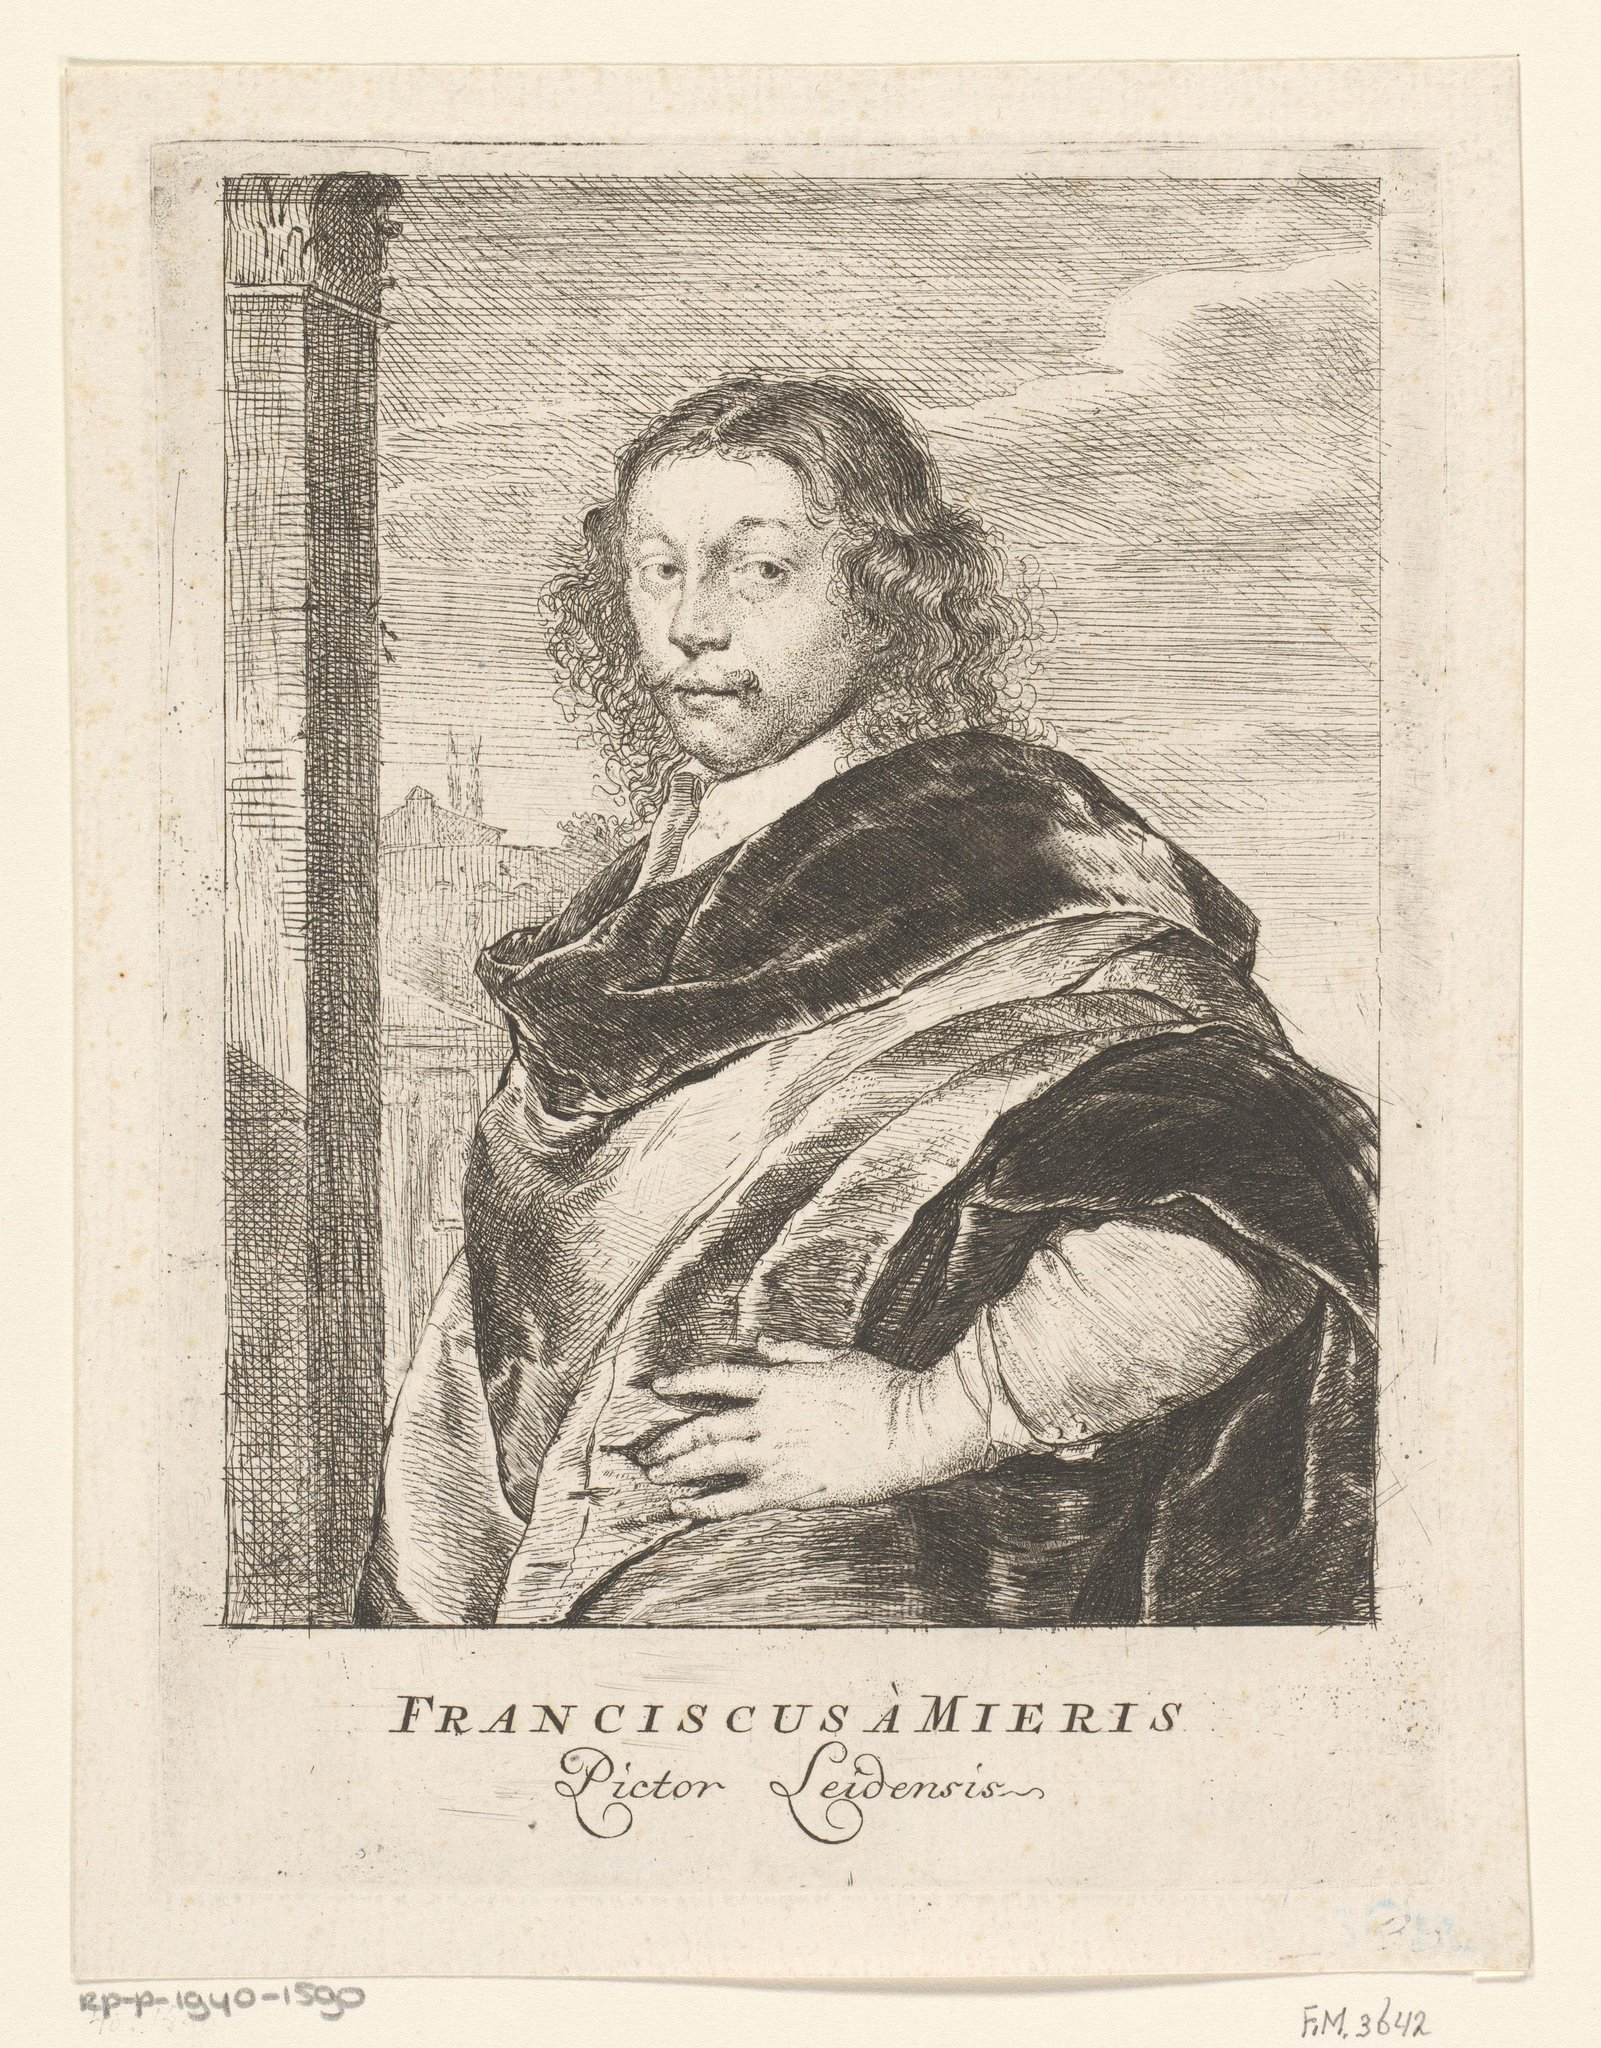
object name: print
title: Portret van Frans van Mieris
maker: carel de moor (ii)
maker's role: draughtsman, painter, print maker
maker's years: 1655-1738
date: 1672-1738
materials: paper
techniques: etching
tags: leiden, painter, print maker, draughtsman, frans van mieris (i), historical persons, portrait, self-portrait of painter, artist in non-work situation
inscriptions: collector's mark: Lugt 2166, collector's mark: Lugt 2760